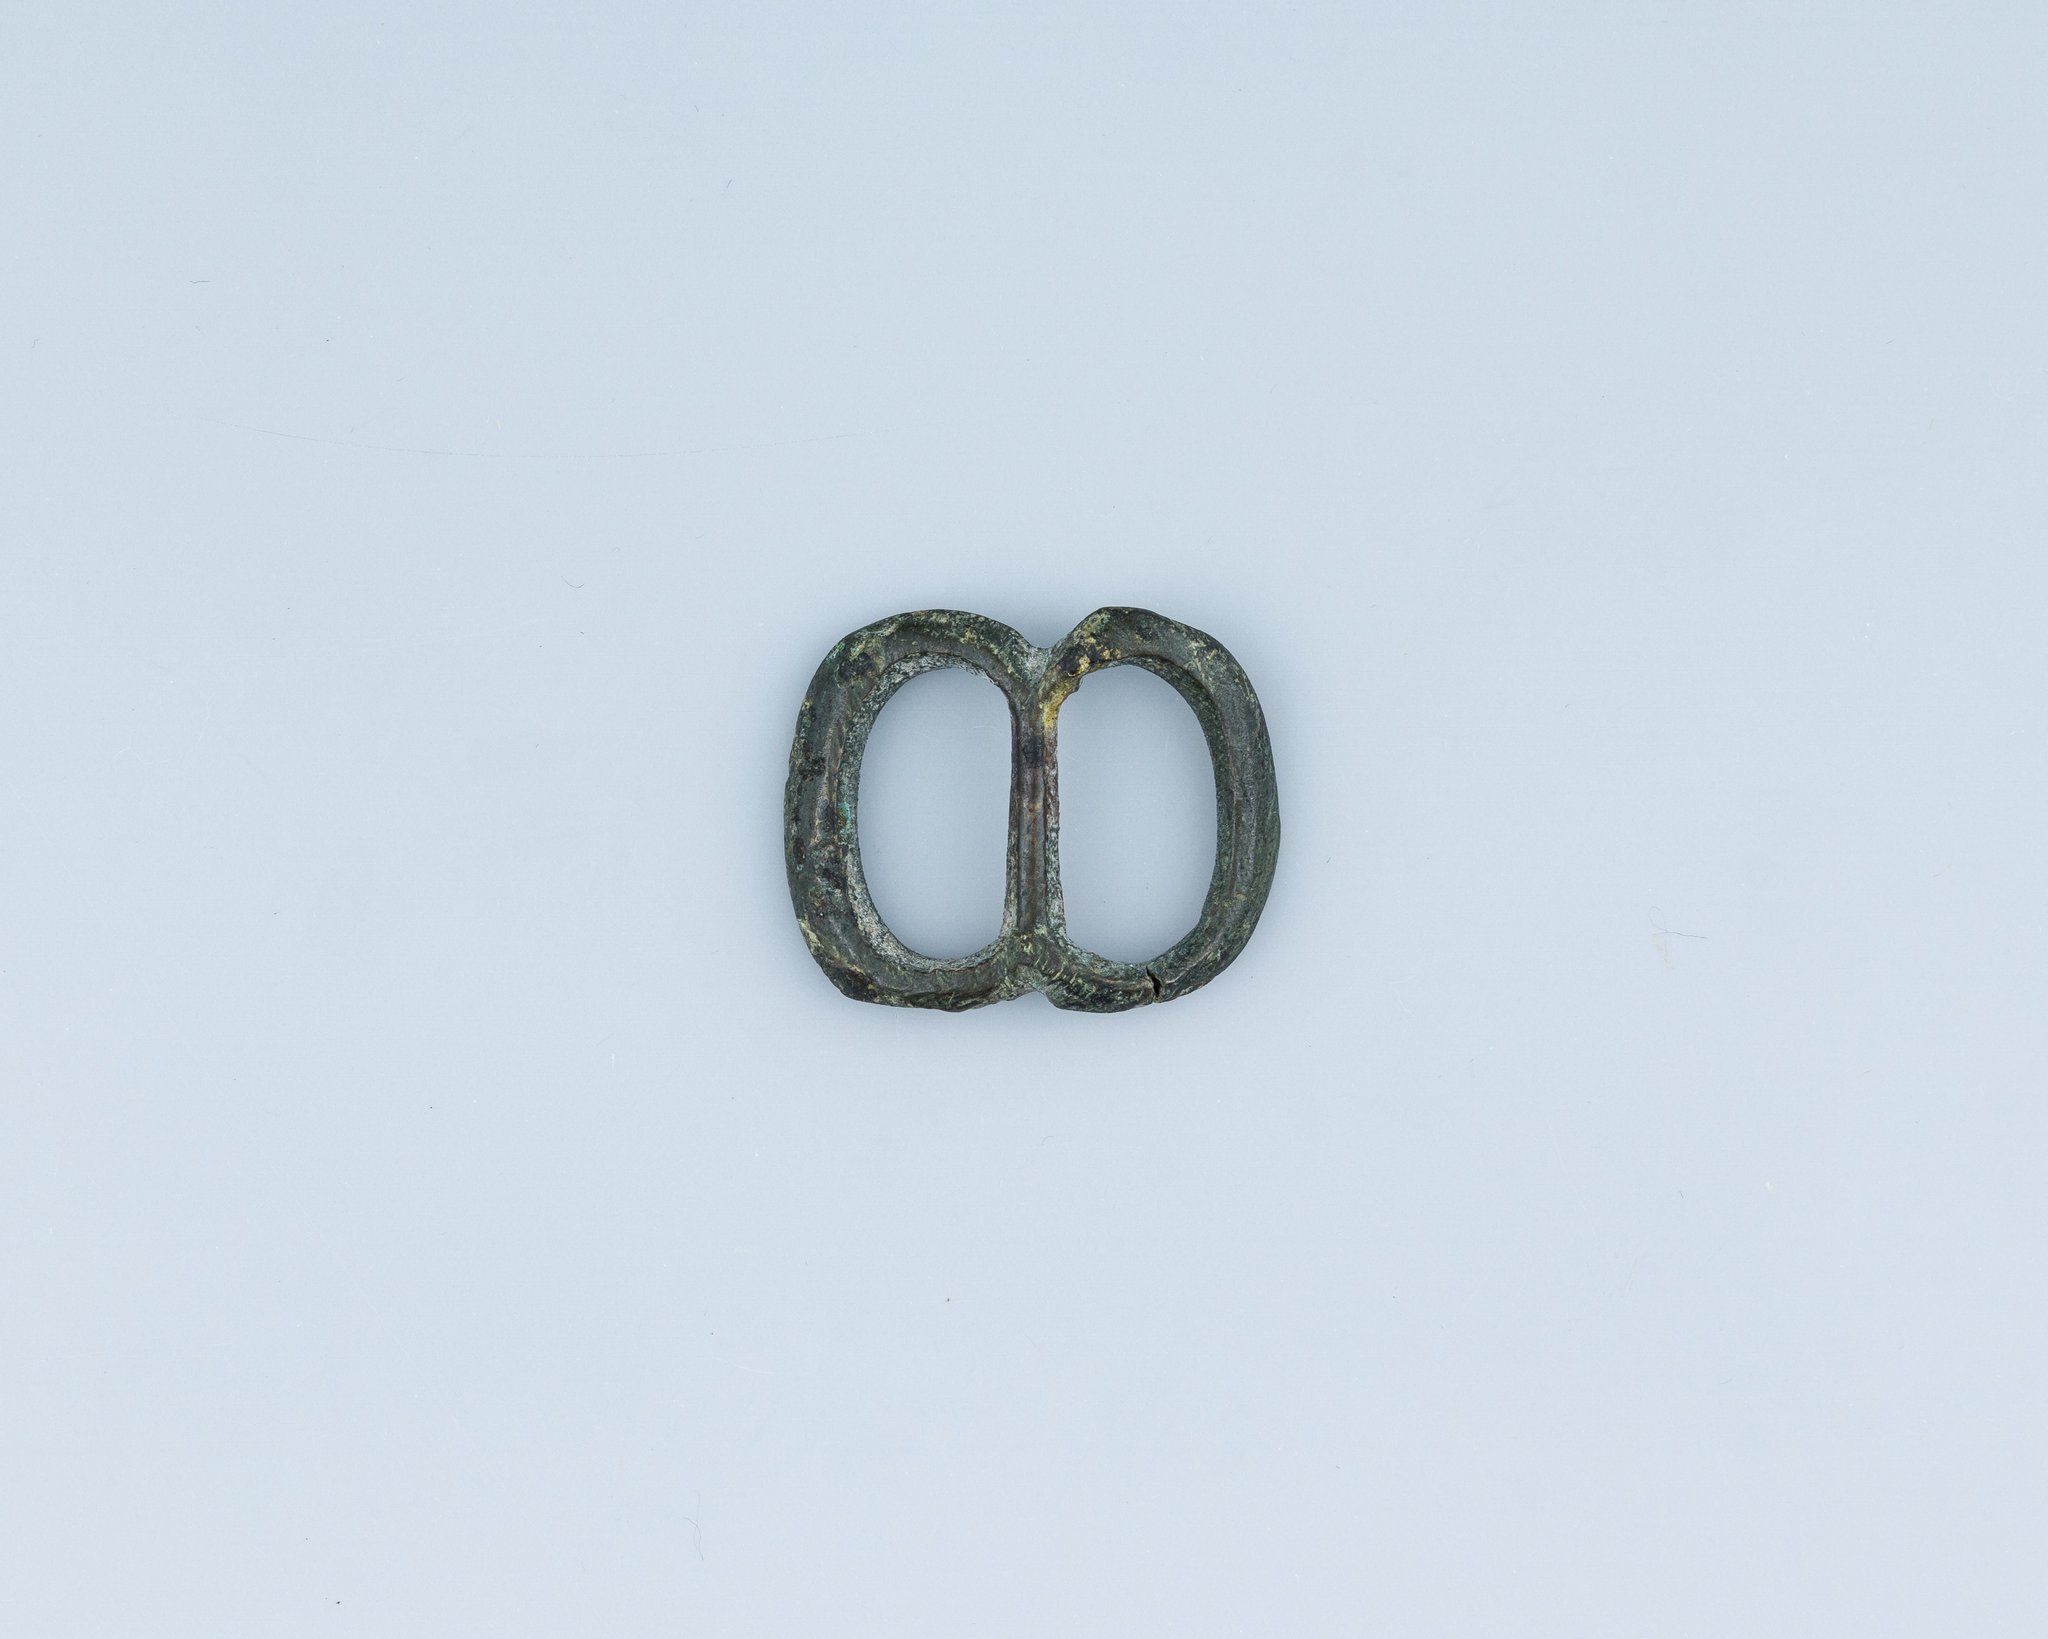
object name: buckle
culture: european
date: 1401-1600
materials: bronze